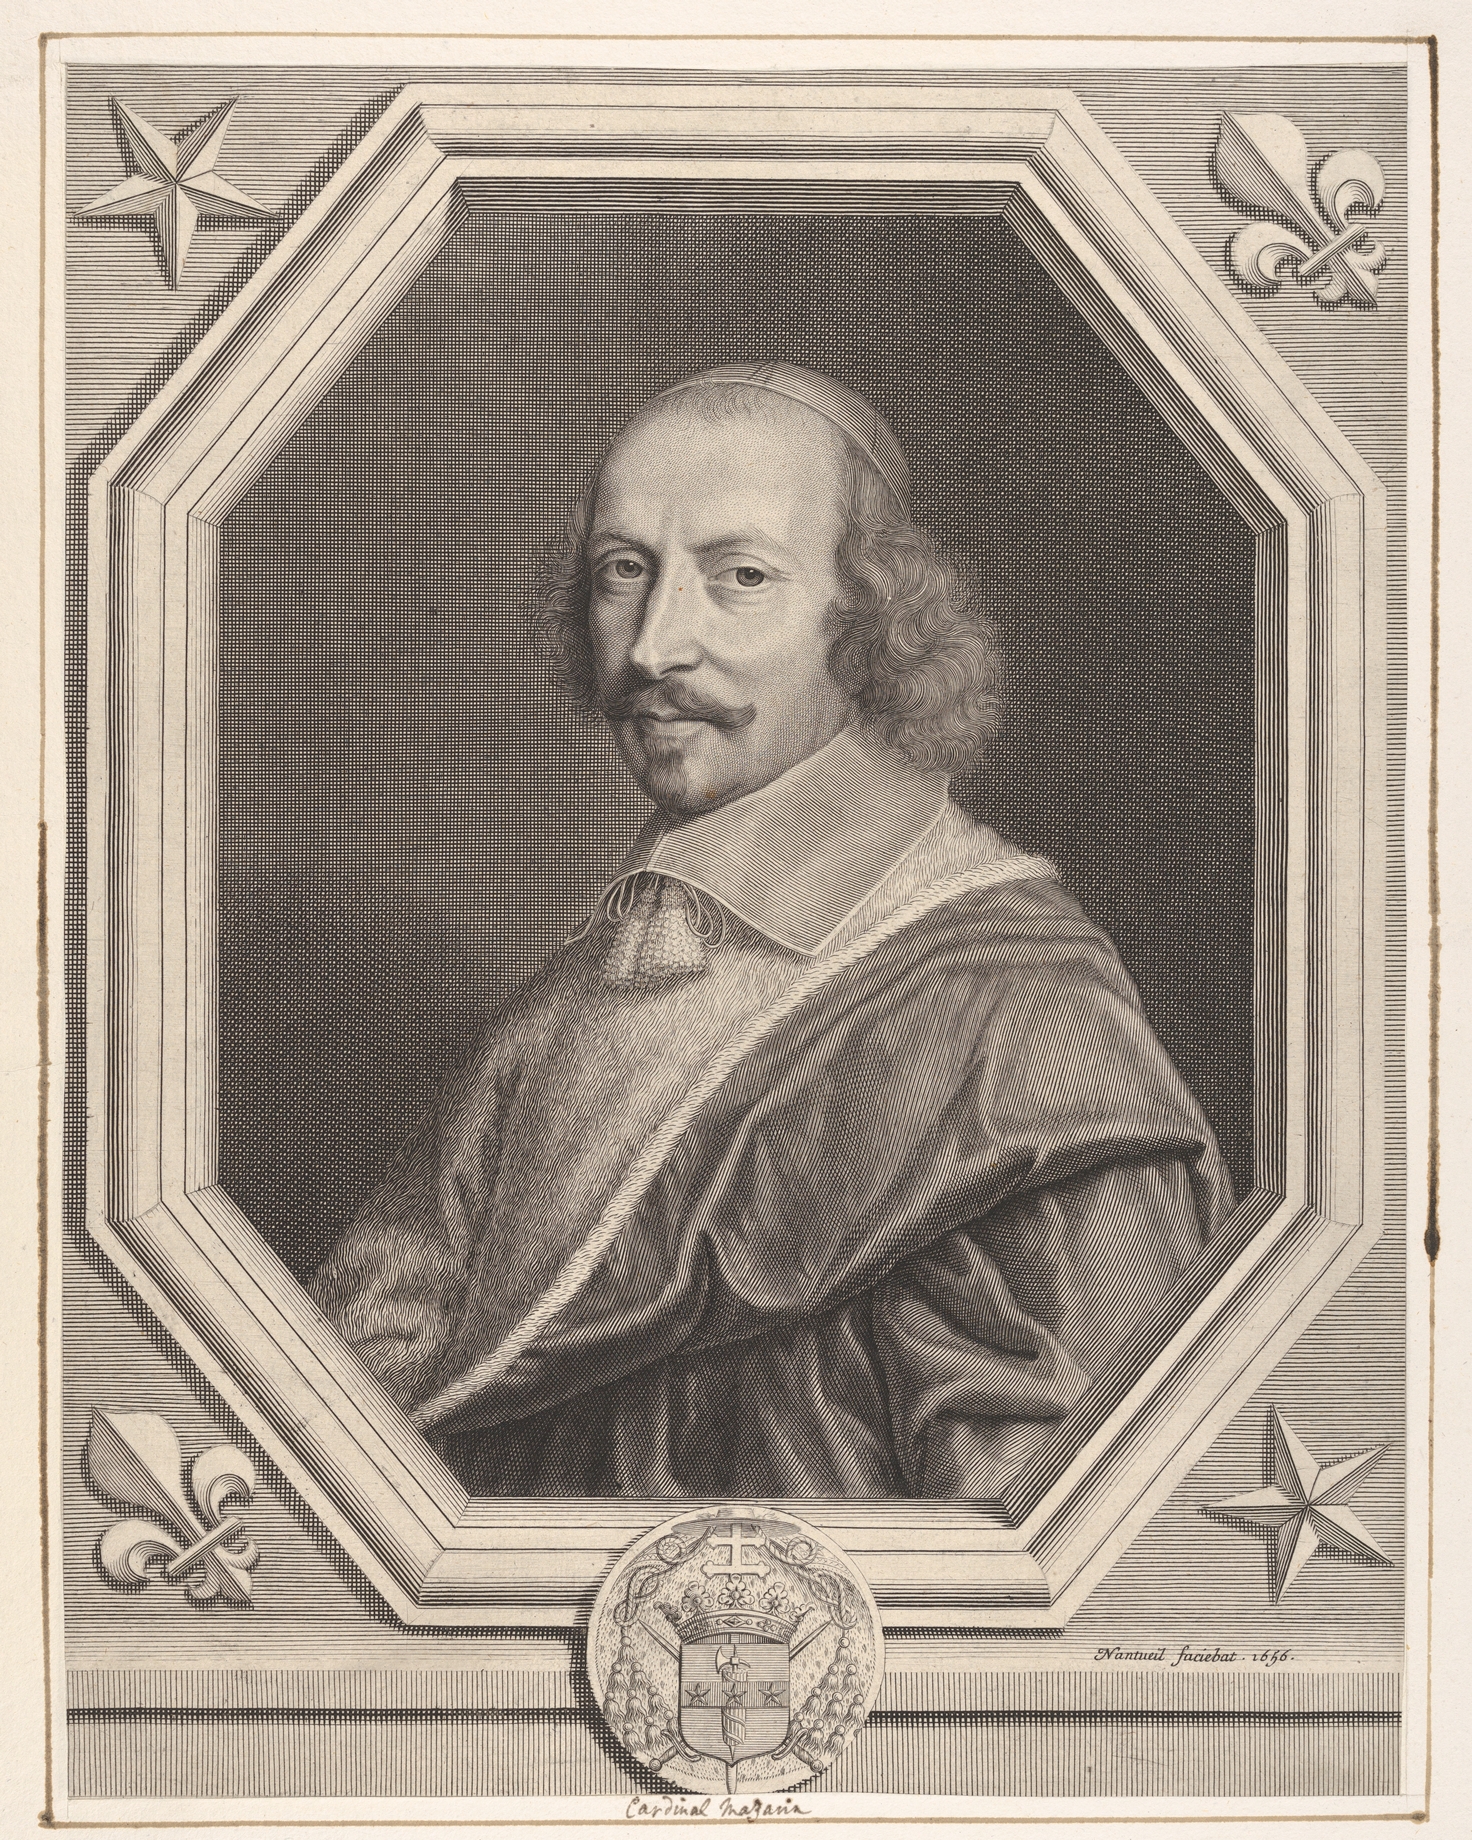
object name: print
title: Cardinal Jules Mazarin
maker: robert nanteuil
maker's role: artist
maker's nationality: french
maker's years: 1623-1678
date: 1656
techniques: engraving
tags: men,portraits,coat of arms